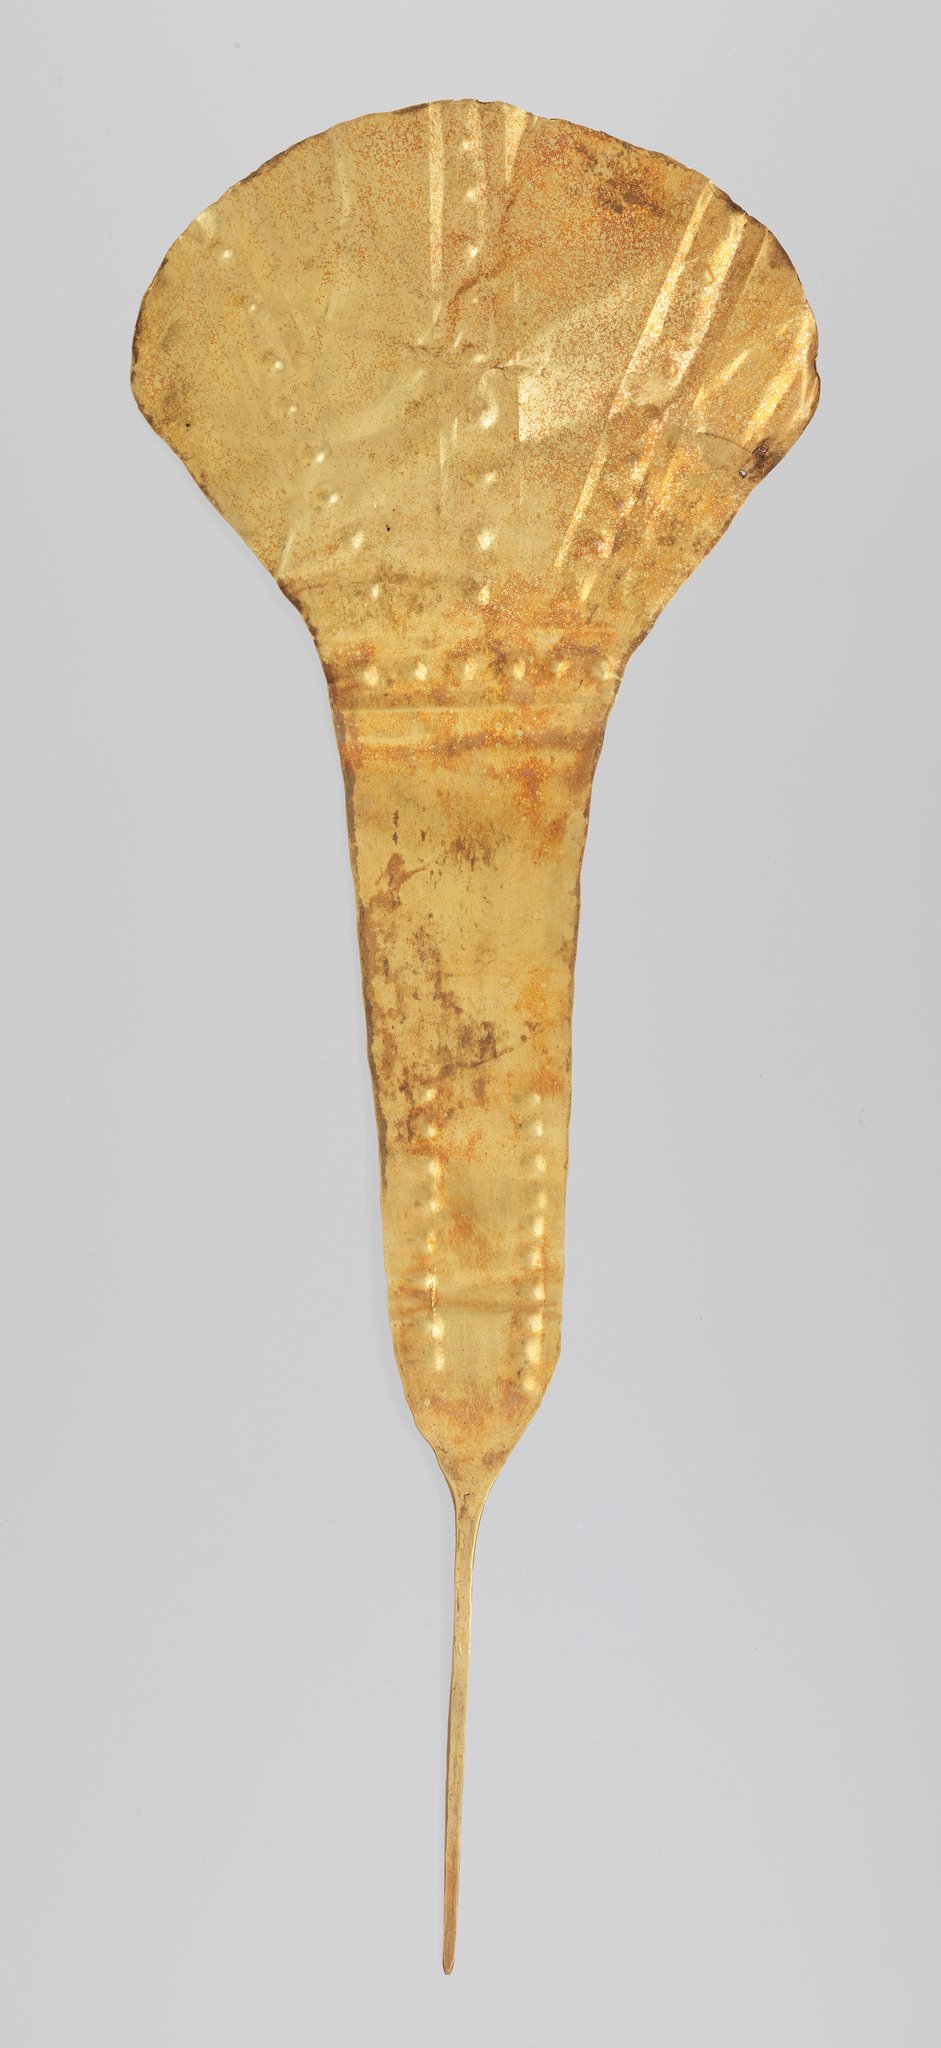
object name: plume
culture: inca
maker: north coast artist(s)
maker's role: artist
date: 900-1400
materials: gold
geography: peru